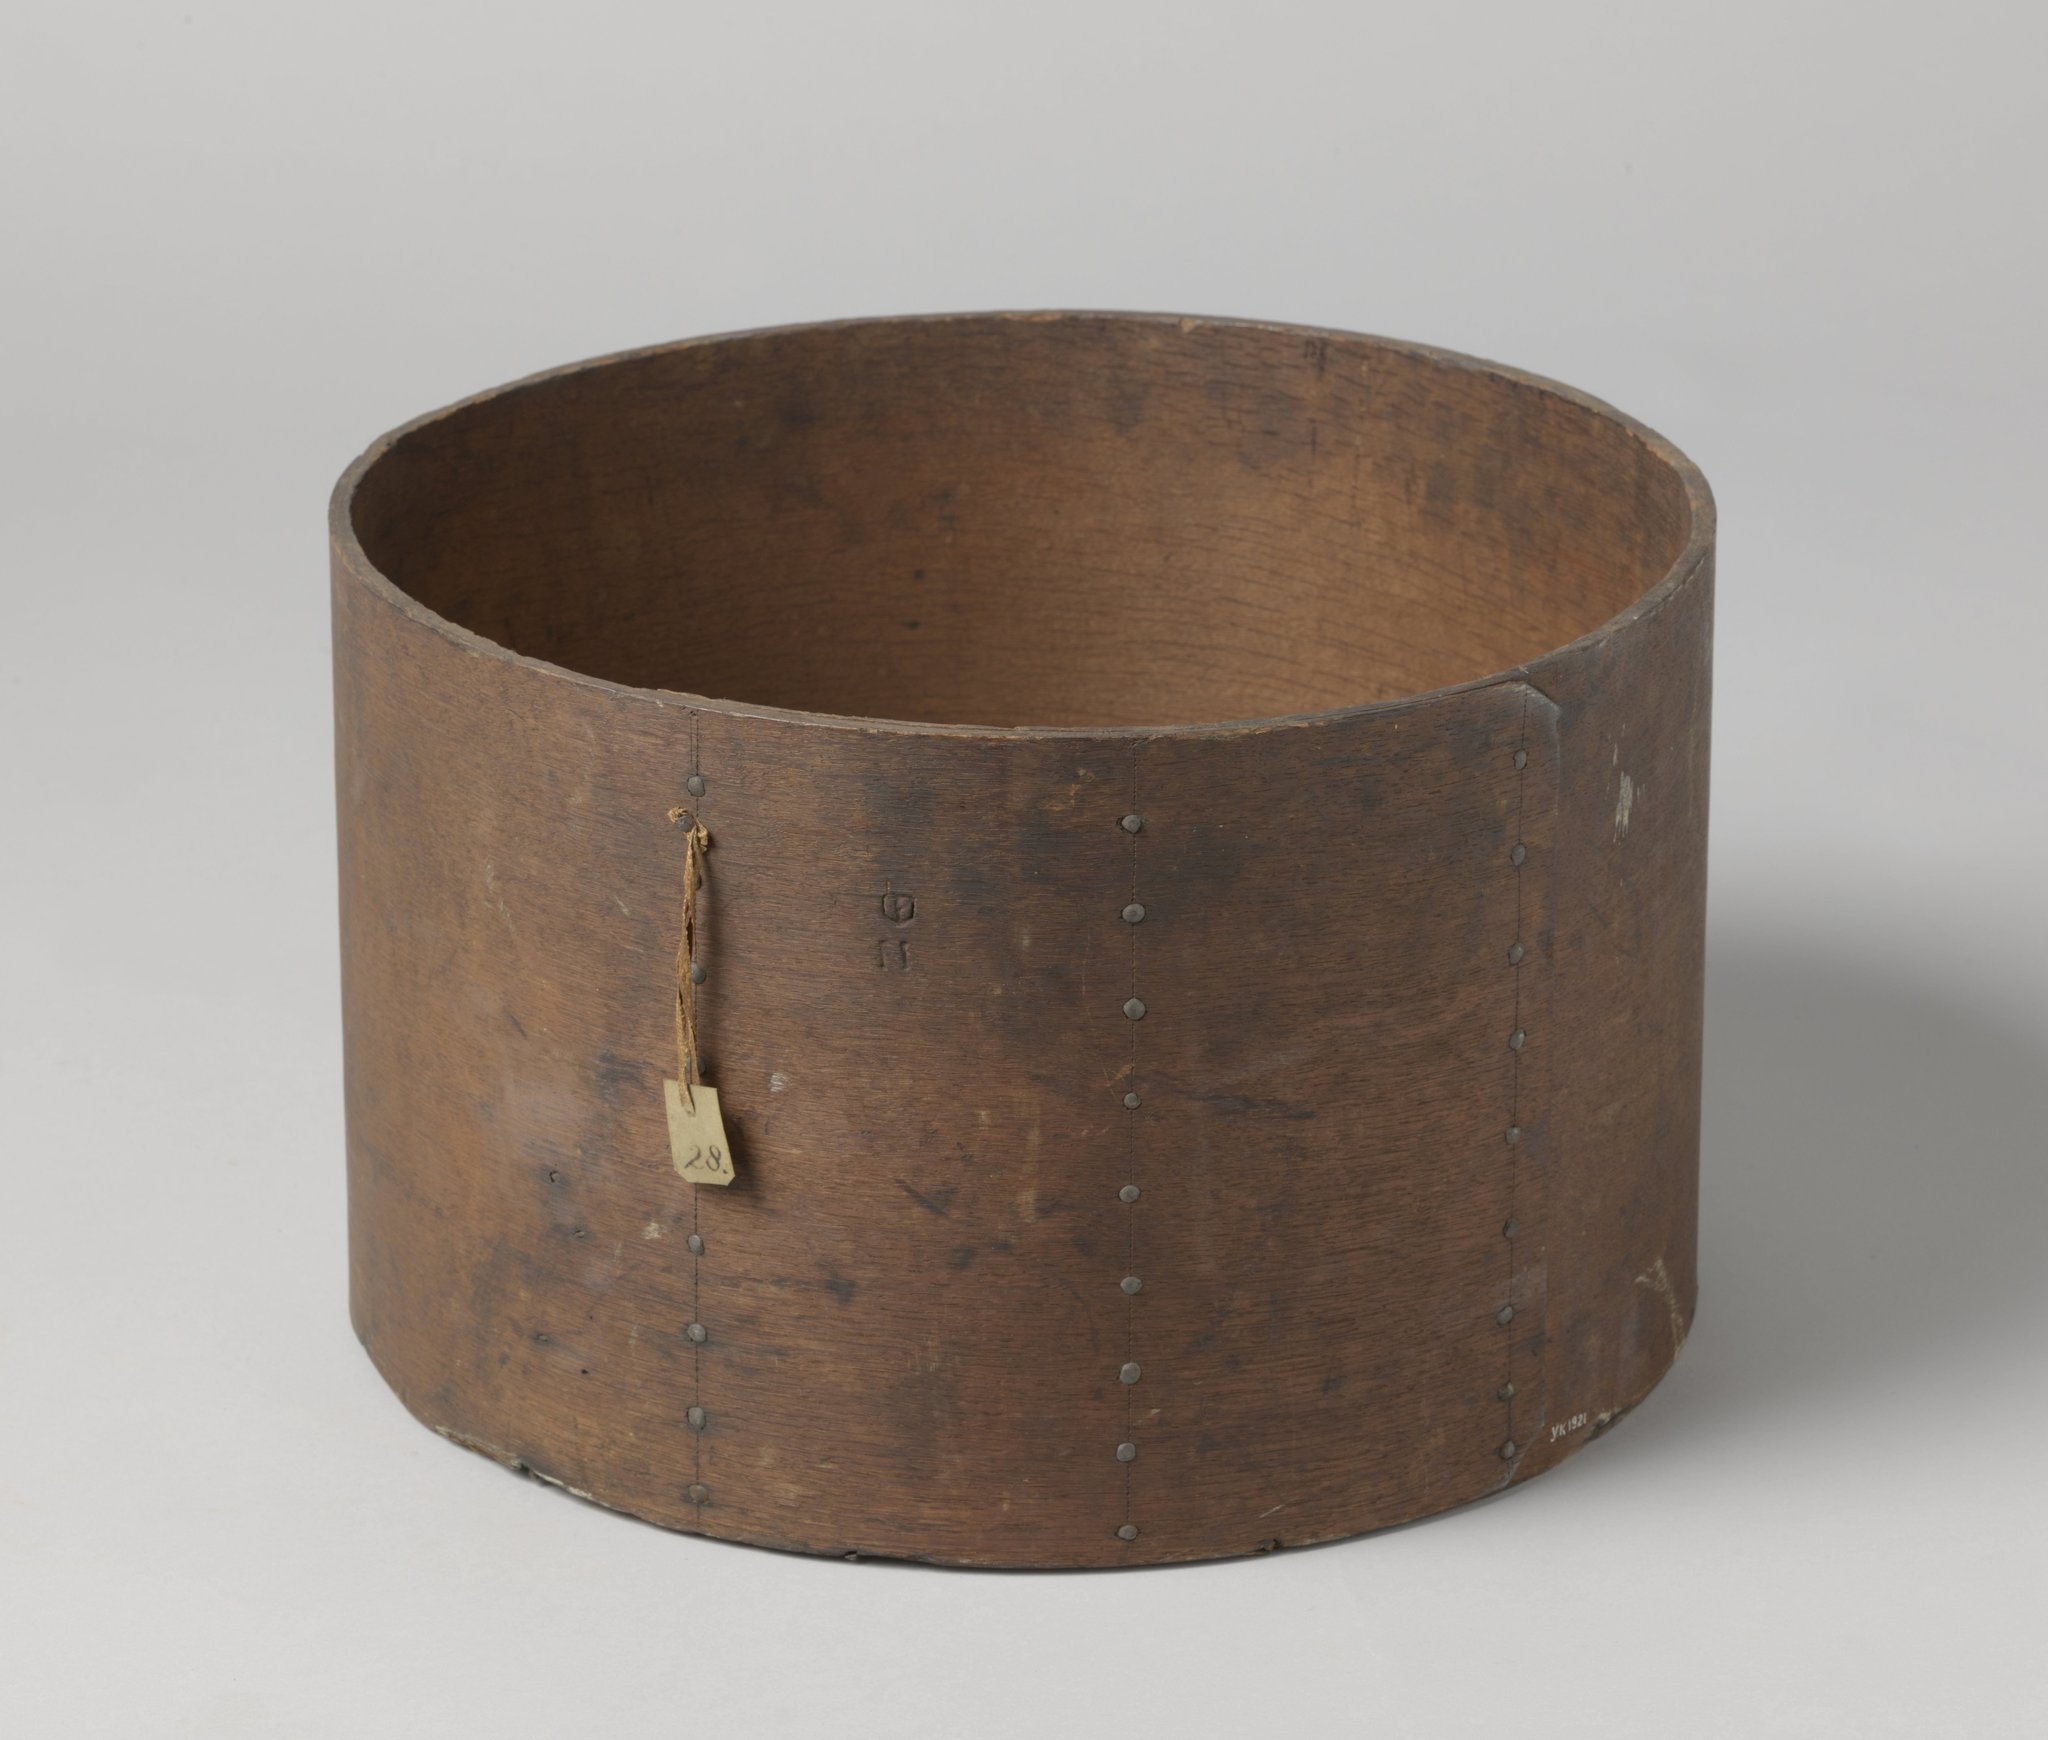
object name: inhoudsmaat droge waren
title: Een Boisseau uit Delft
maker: Anonymous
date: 1800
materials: wood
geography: delft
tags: delft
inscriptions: : ‘N’, title: ‘Delft / Een Aggelen’, title: ‘De Delft un Boisseau’, number: ‘28’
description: Spanen inhoudsmaat voor droge waren van 1 Boisseau met blok waarop het wapen van Delft, v.z.v. merk, label aan een lintje en etiketten.